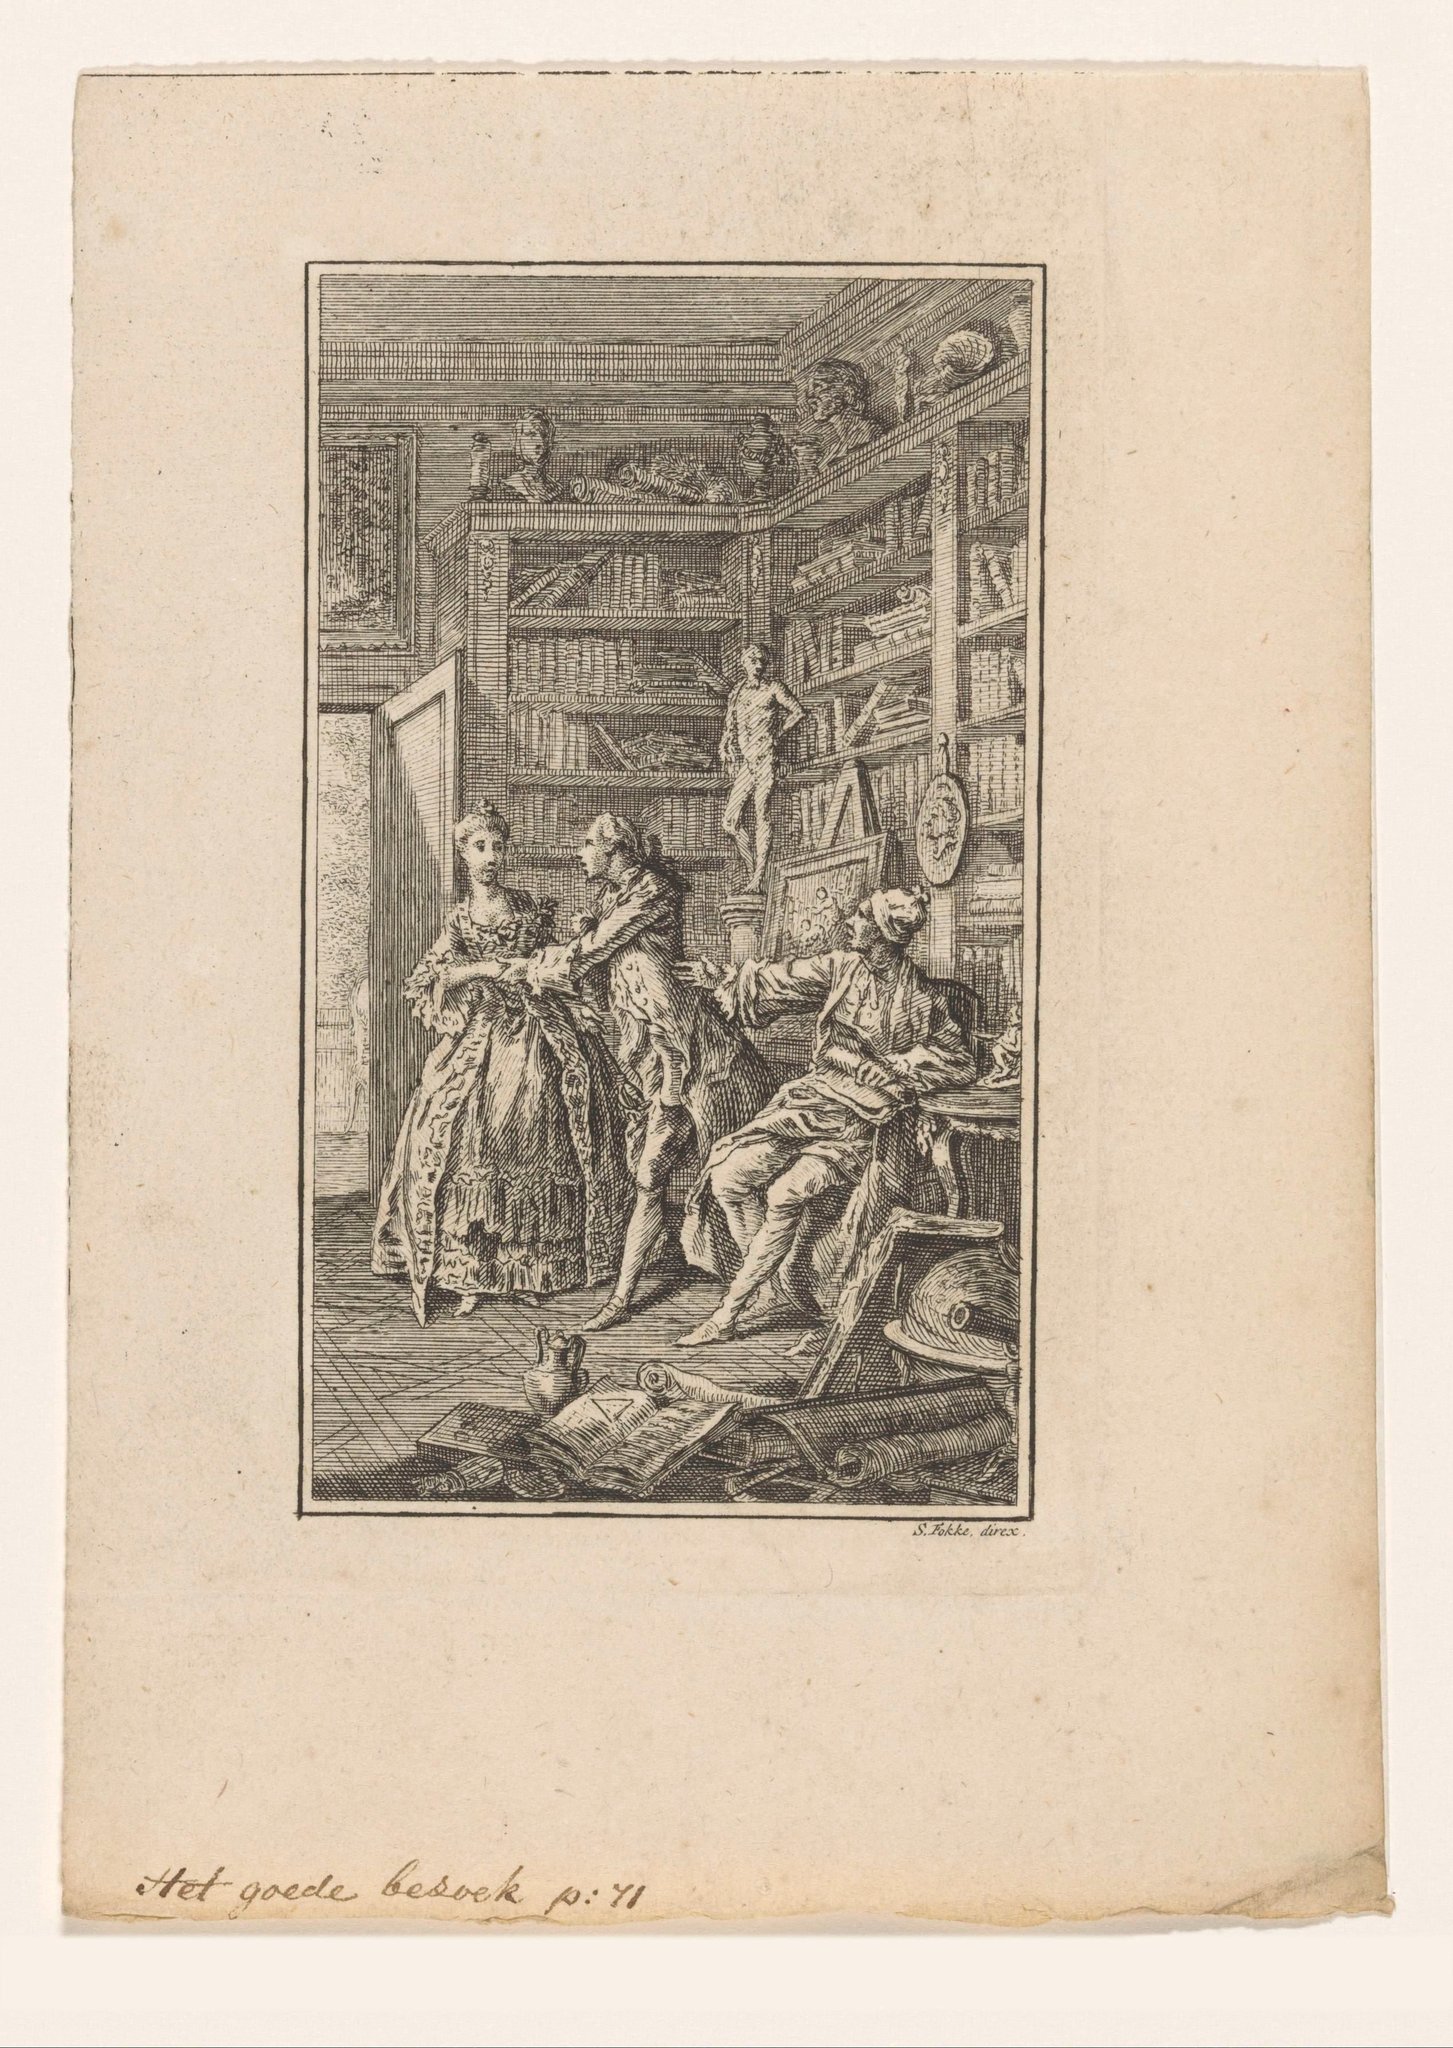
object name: print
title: Twee mannen en een vrouw in een bibliotheek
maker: simon fokke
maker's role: draughtsman, print maker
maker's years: 1712-1784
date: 1722-1784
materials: paper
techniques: etching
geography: amsterdam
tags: study; 'studiolo'; library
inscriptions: inscription: ‘Het goede bezoek p: 71’, collector's mark: Lugt 2228, collector's mark: Lugt 4779, collector's mark: Lugt 4780